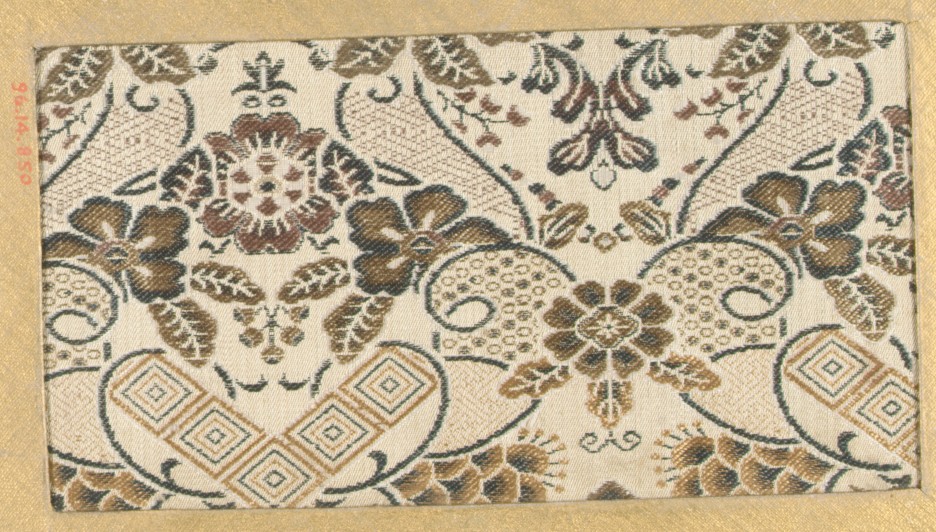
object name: piece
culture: japanese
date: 1701-1900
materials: silk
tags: leaves